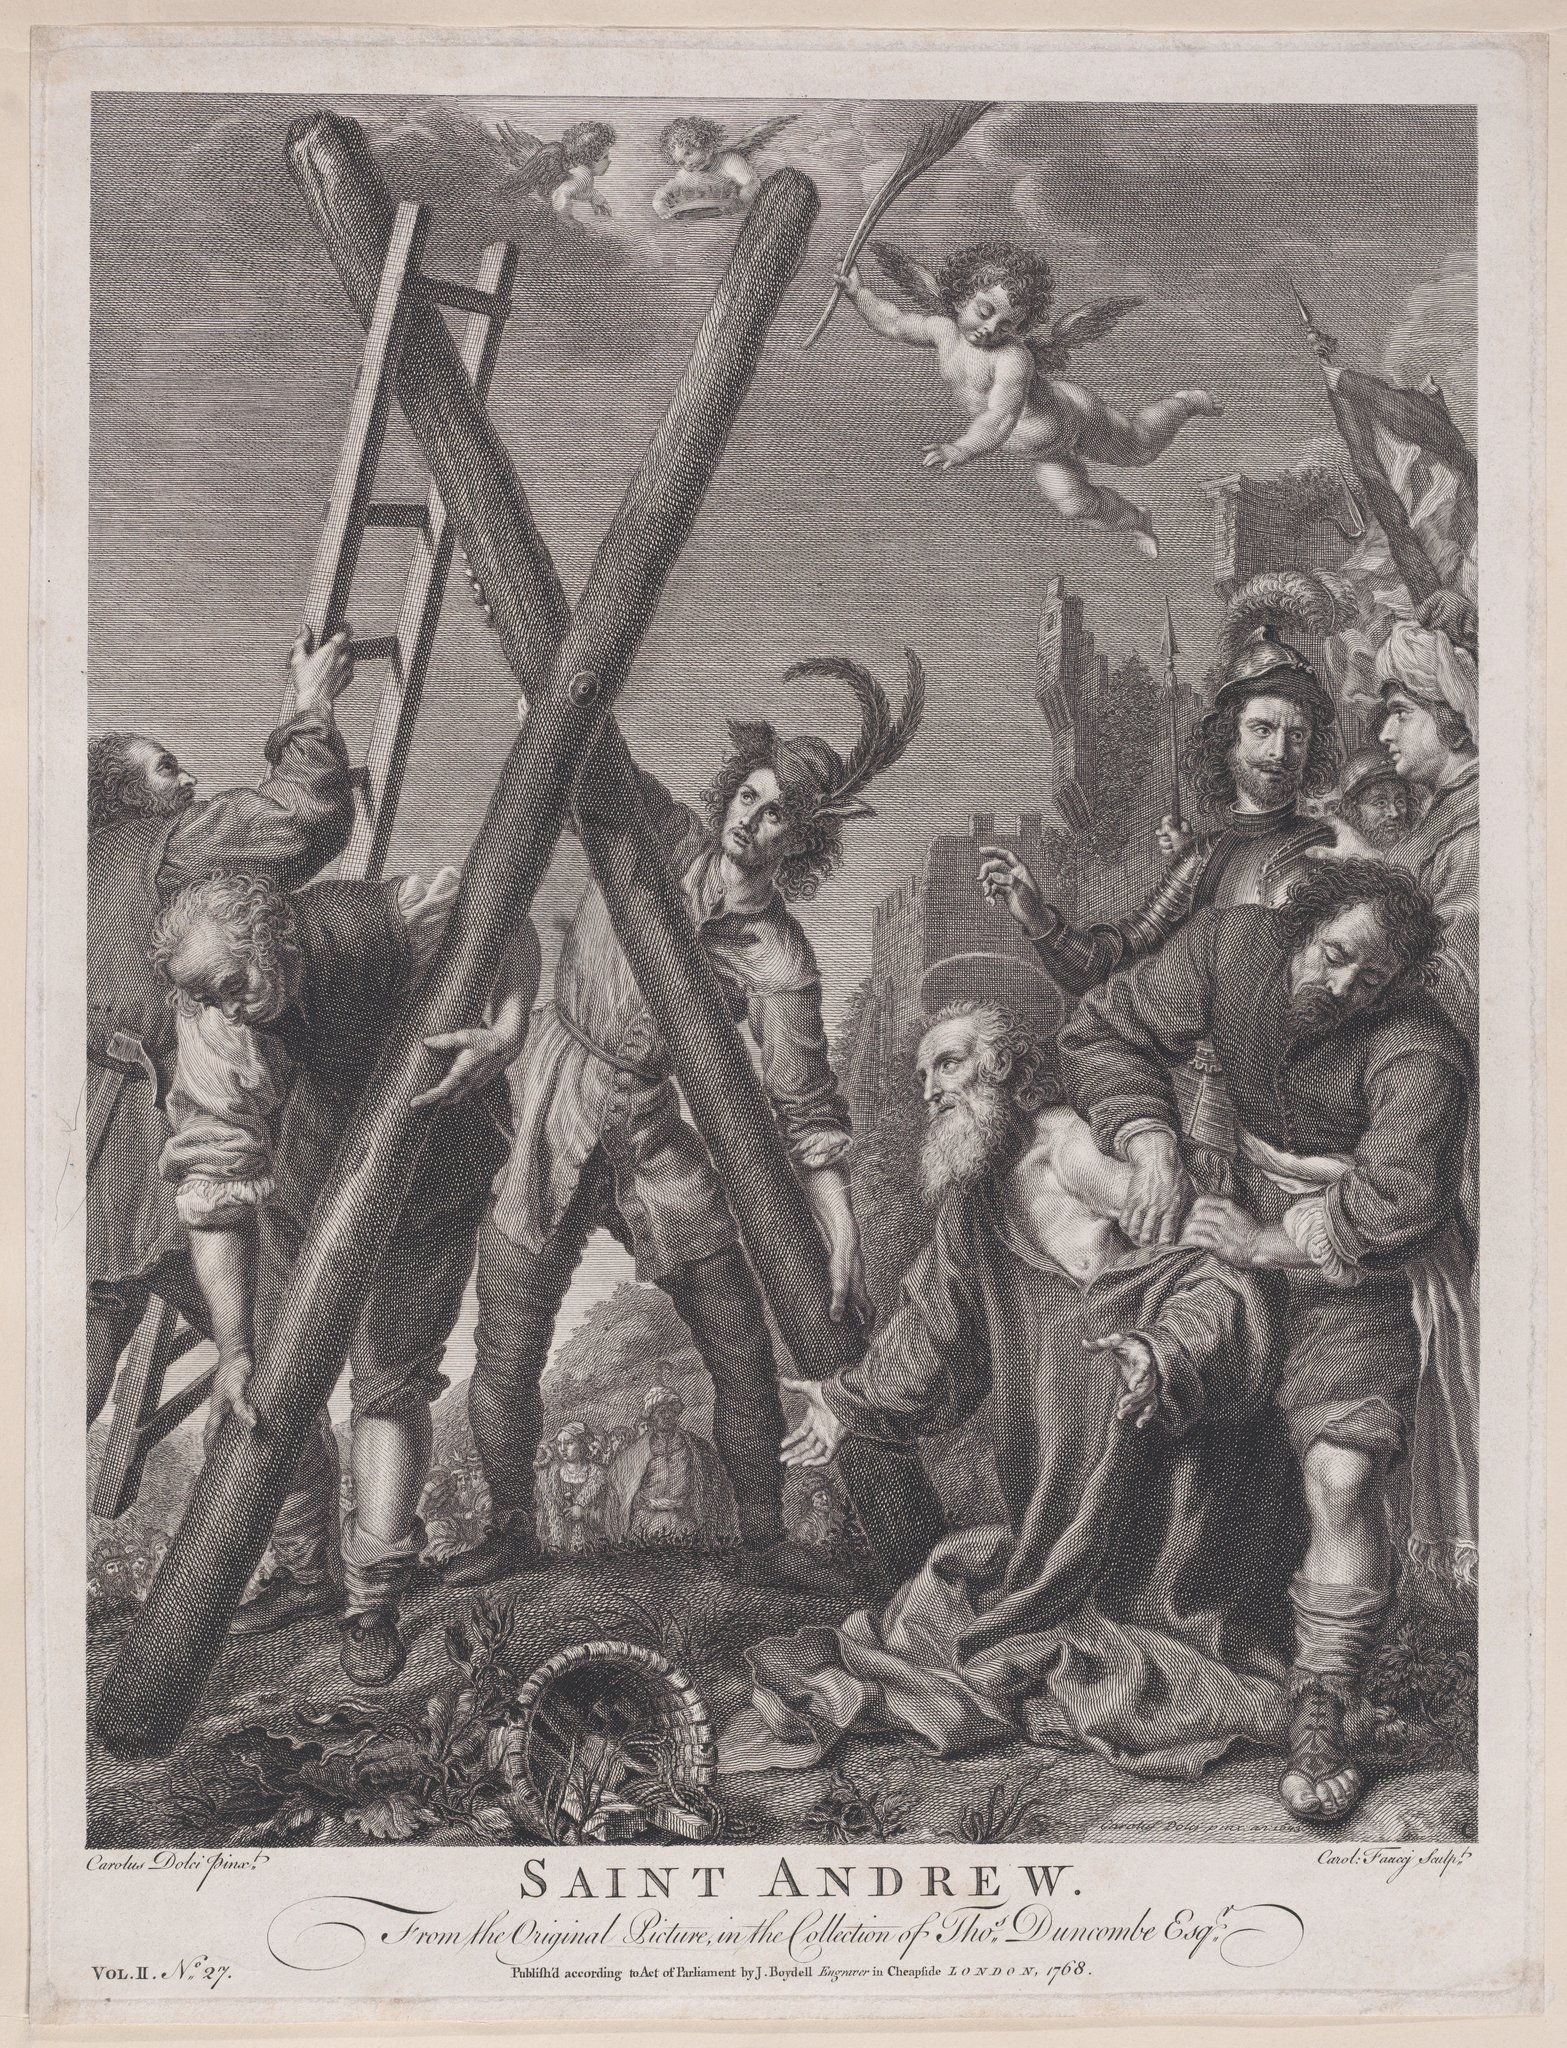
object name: print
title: Saint Andrew kneeling and adoring the cross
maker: carlo faucci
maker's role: artist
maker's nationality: italian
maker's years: 1729-1784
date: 1768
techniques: engraving, etching